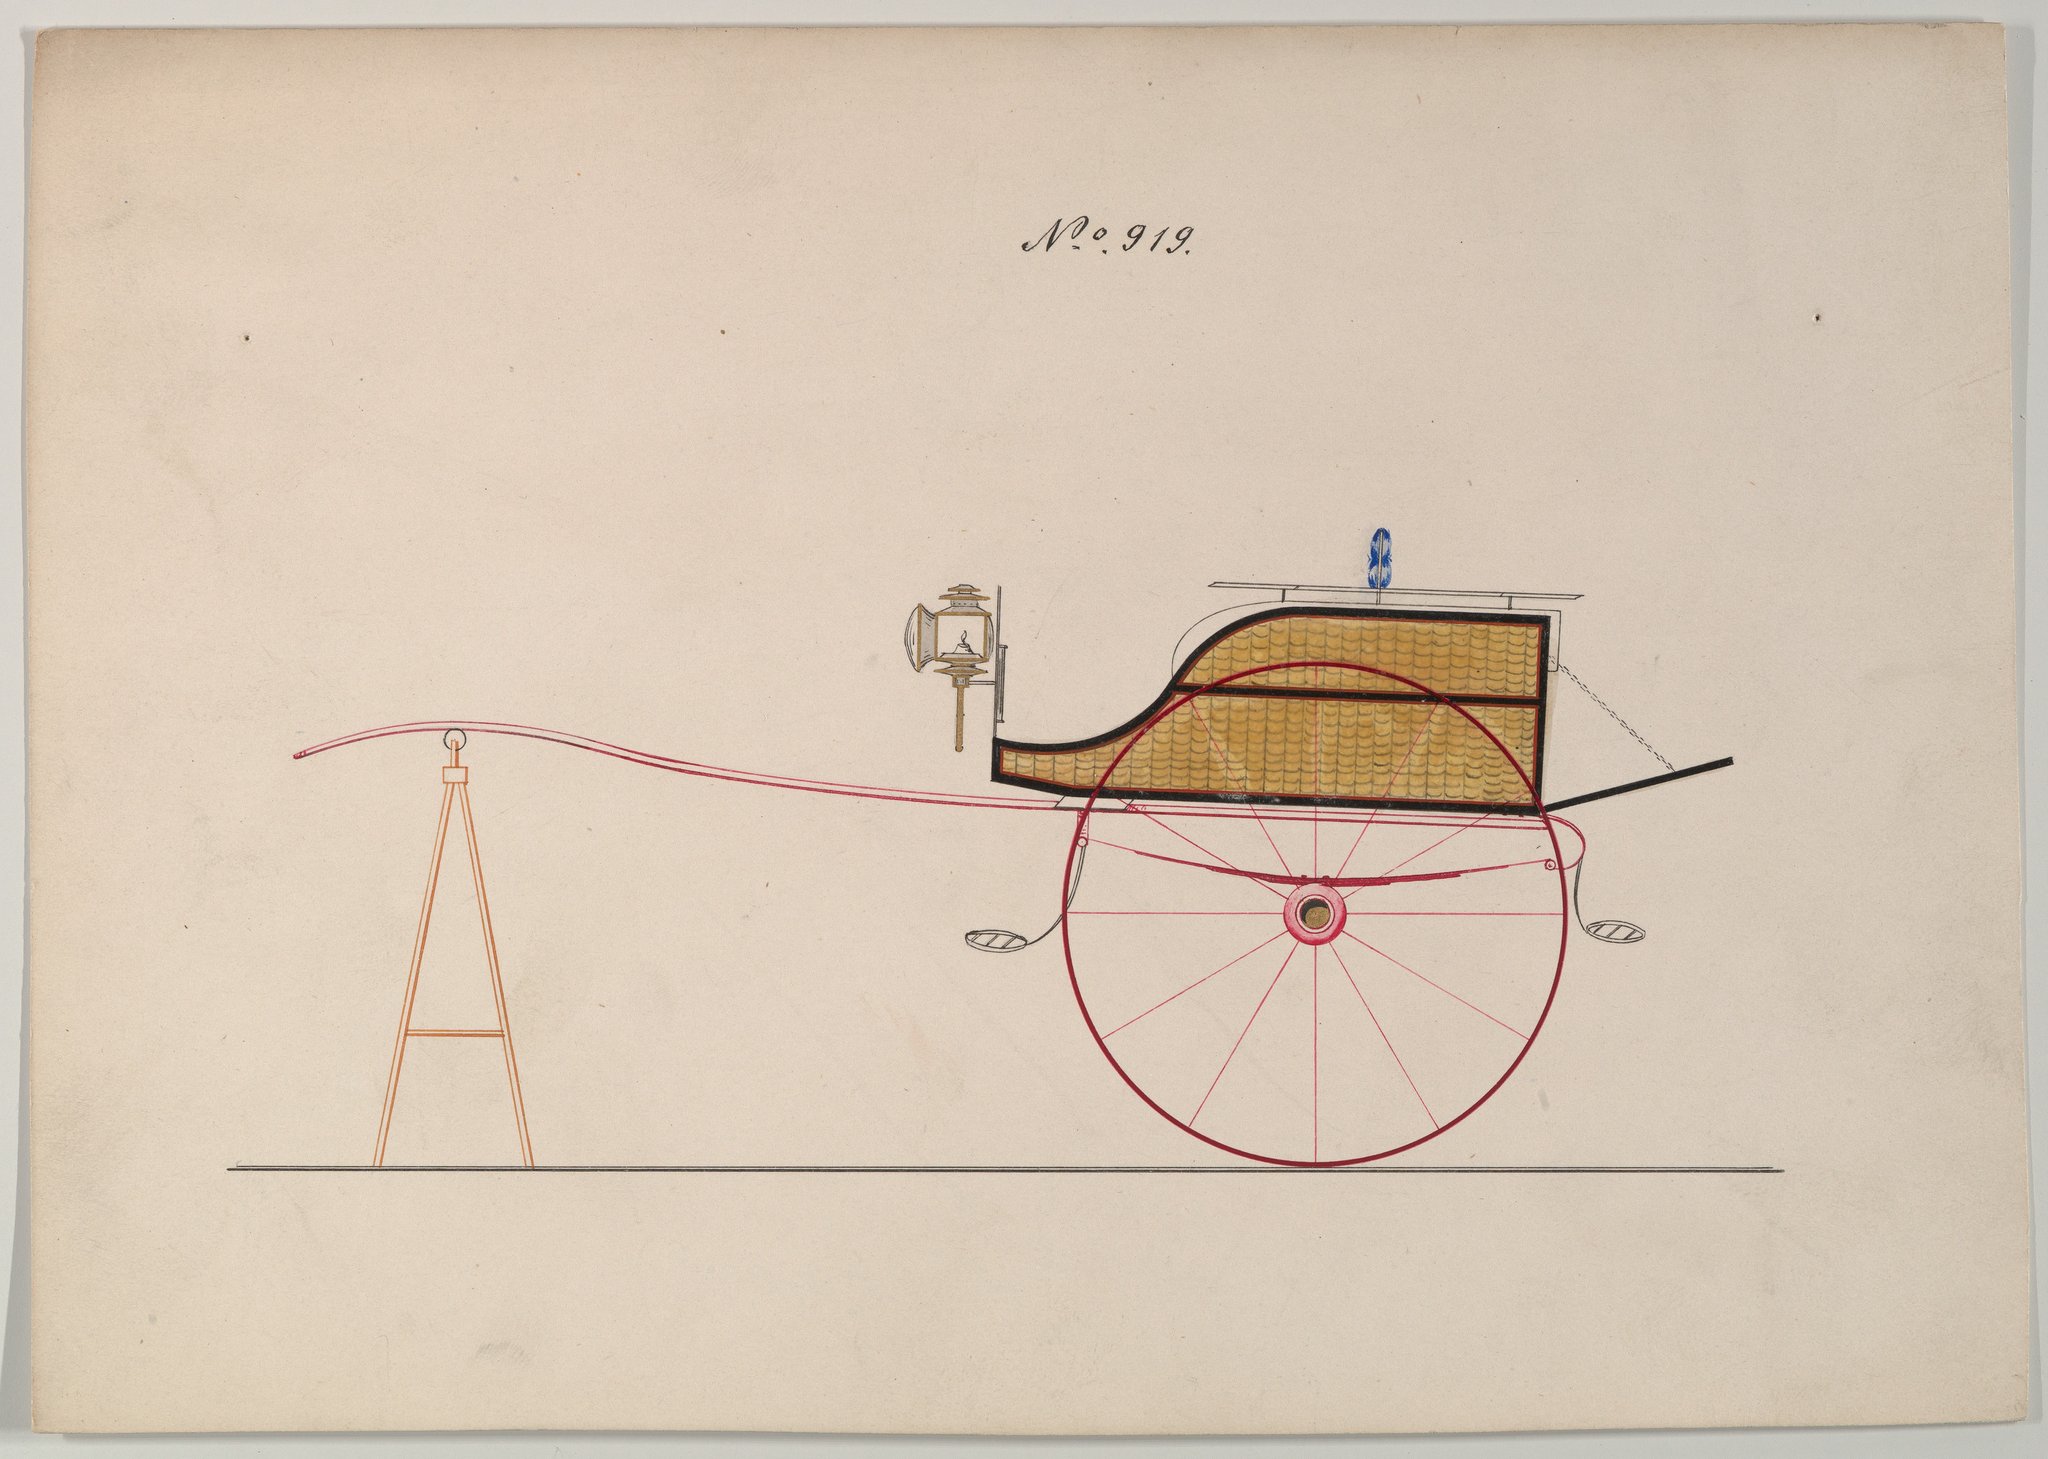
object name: drawing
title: Dog Cart # 919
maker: brewster & co.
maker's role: manufacturer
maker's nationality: american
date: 1870-1874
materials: gouache, gum arabic, ink, watercolor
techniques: pen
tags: carriages